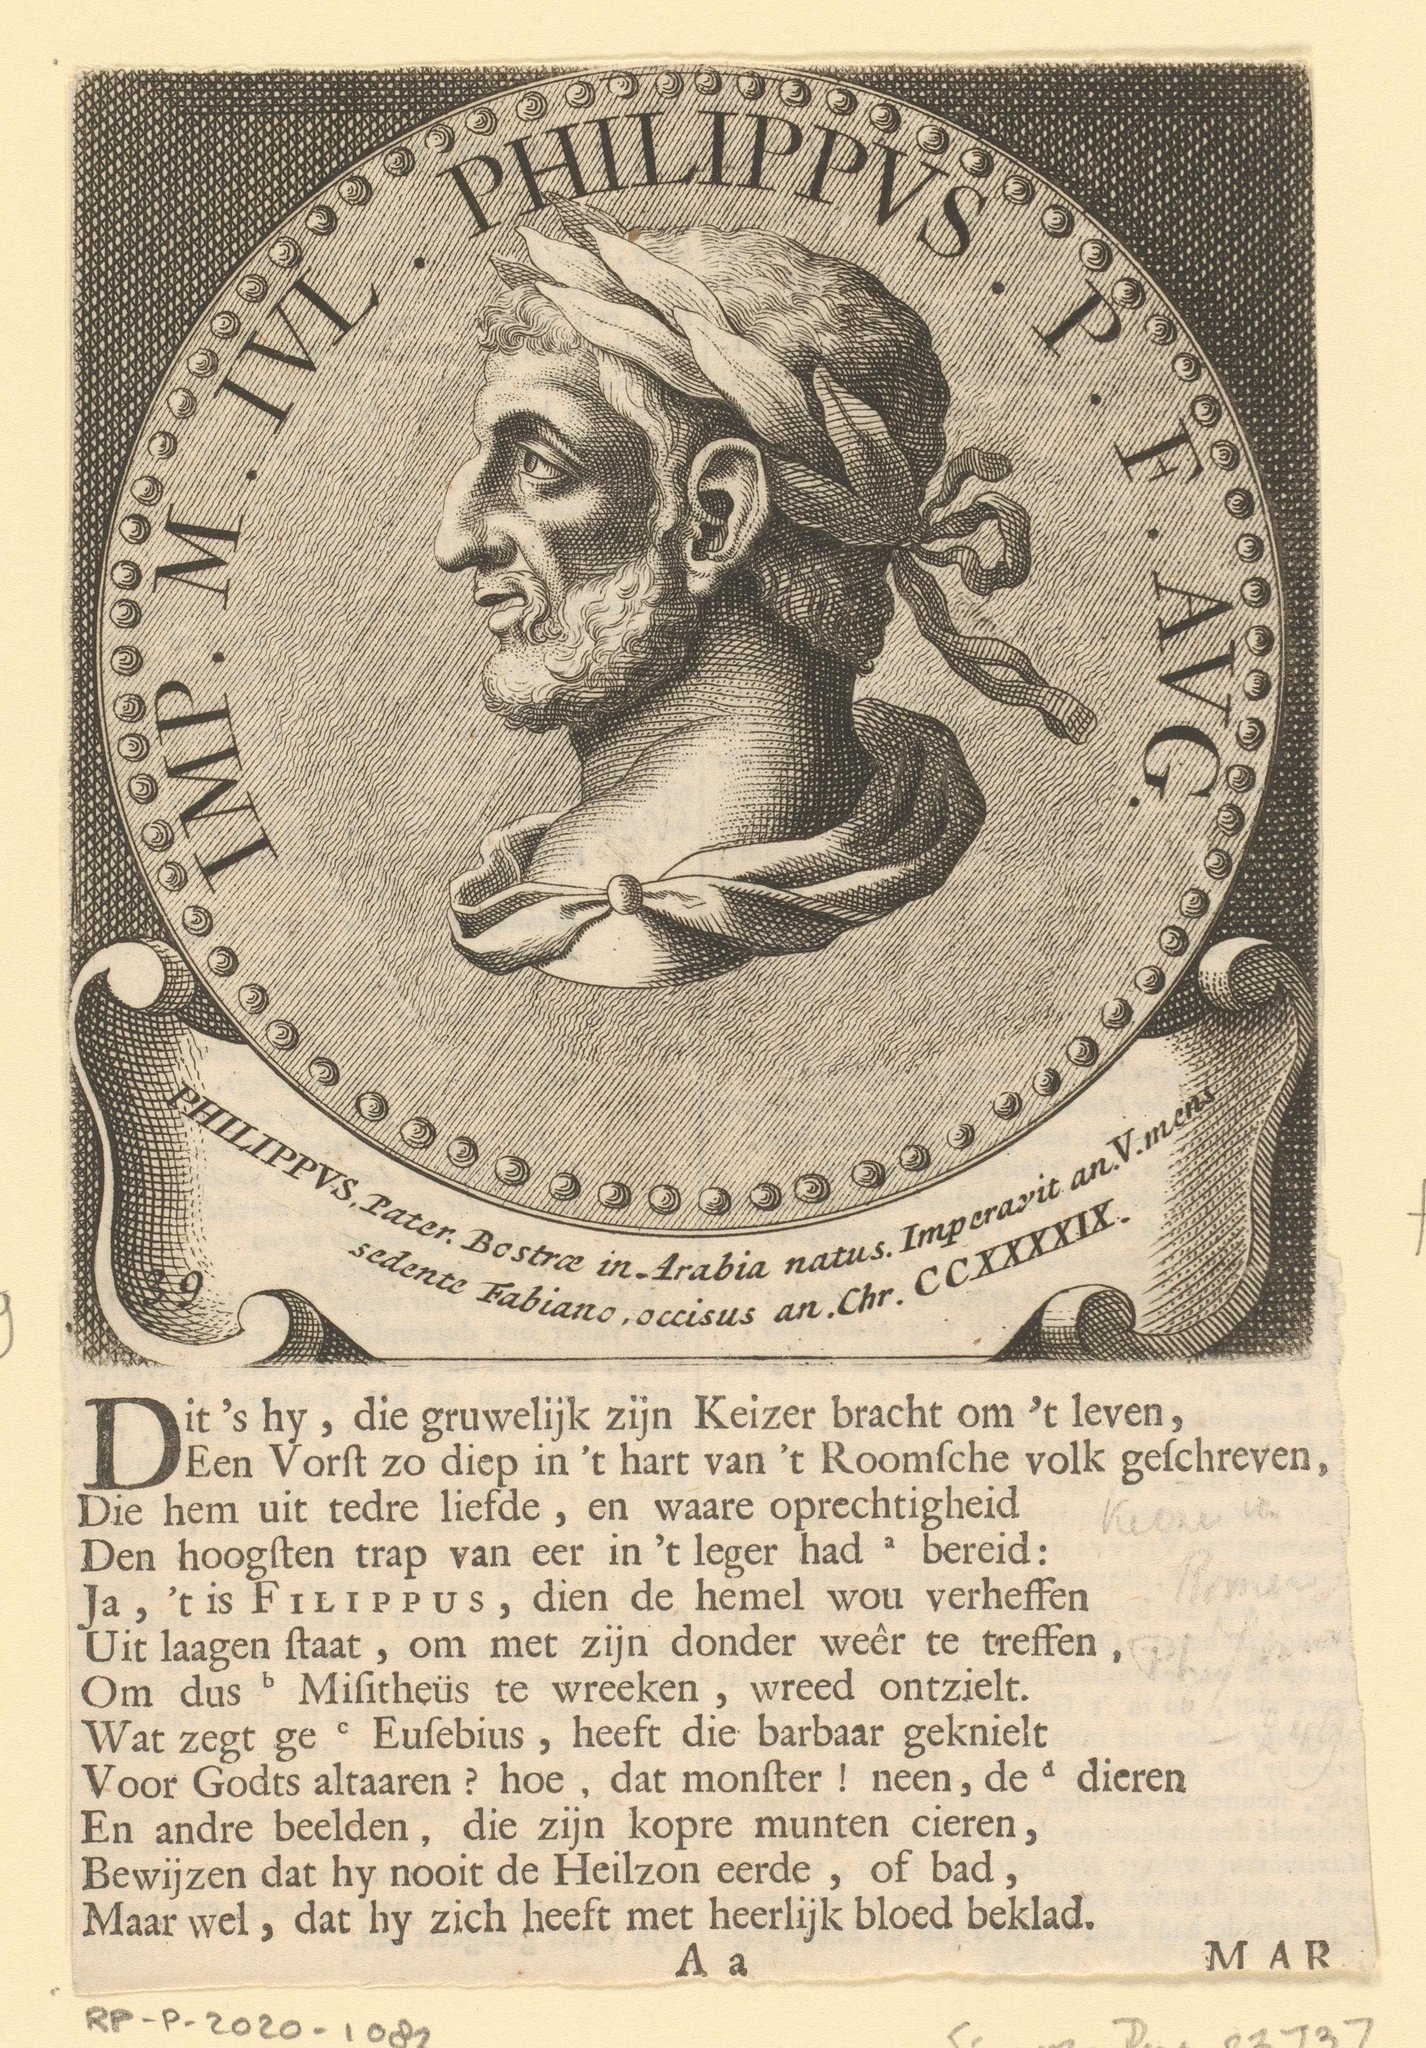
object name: book illustration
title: Portret van keizer Philippus I Arabs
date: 1697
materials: paper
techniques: engraving, etching, letterpress printing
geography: utrecht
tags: historical persons, emperor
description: Prent uit: Bogaert, Abraham. De Roomsche monarchy, vertoont in de muntbeelden der westersche en oostersche keizeren (...). Utrecht: François Halma en Willem van de Water, 1697, p. 185. Eerste staat verschenen in een grotere prent met twaalf portretten, gedateerd 1695.